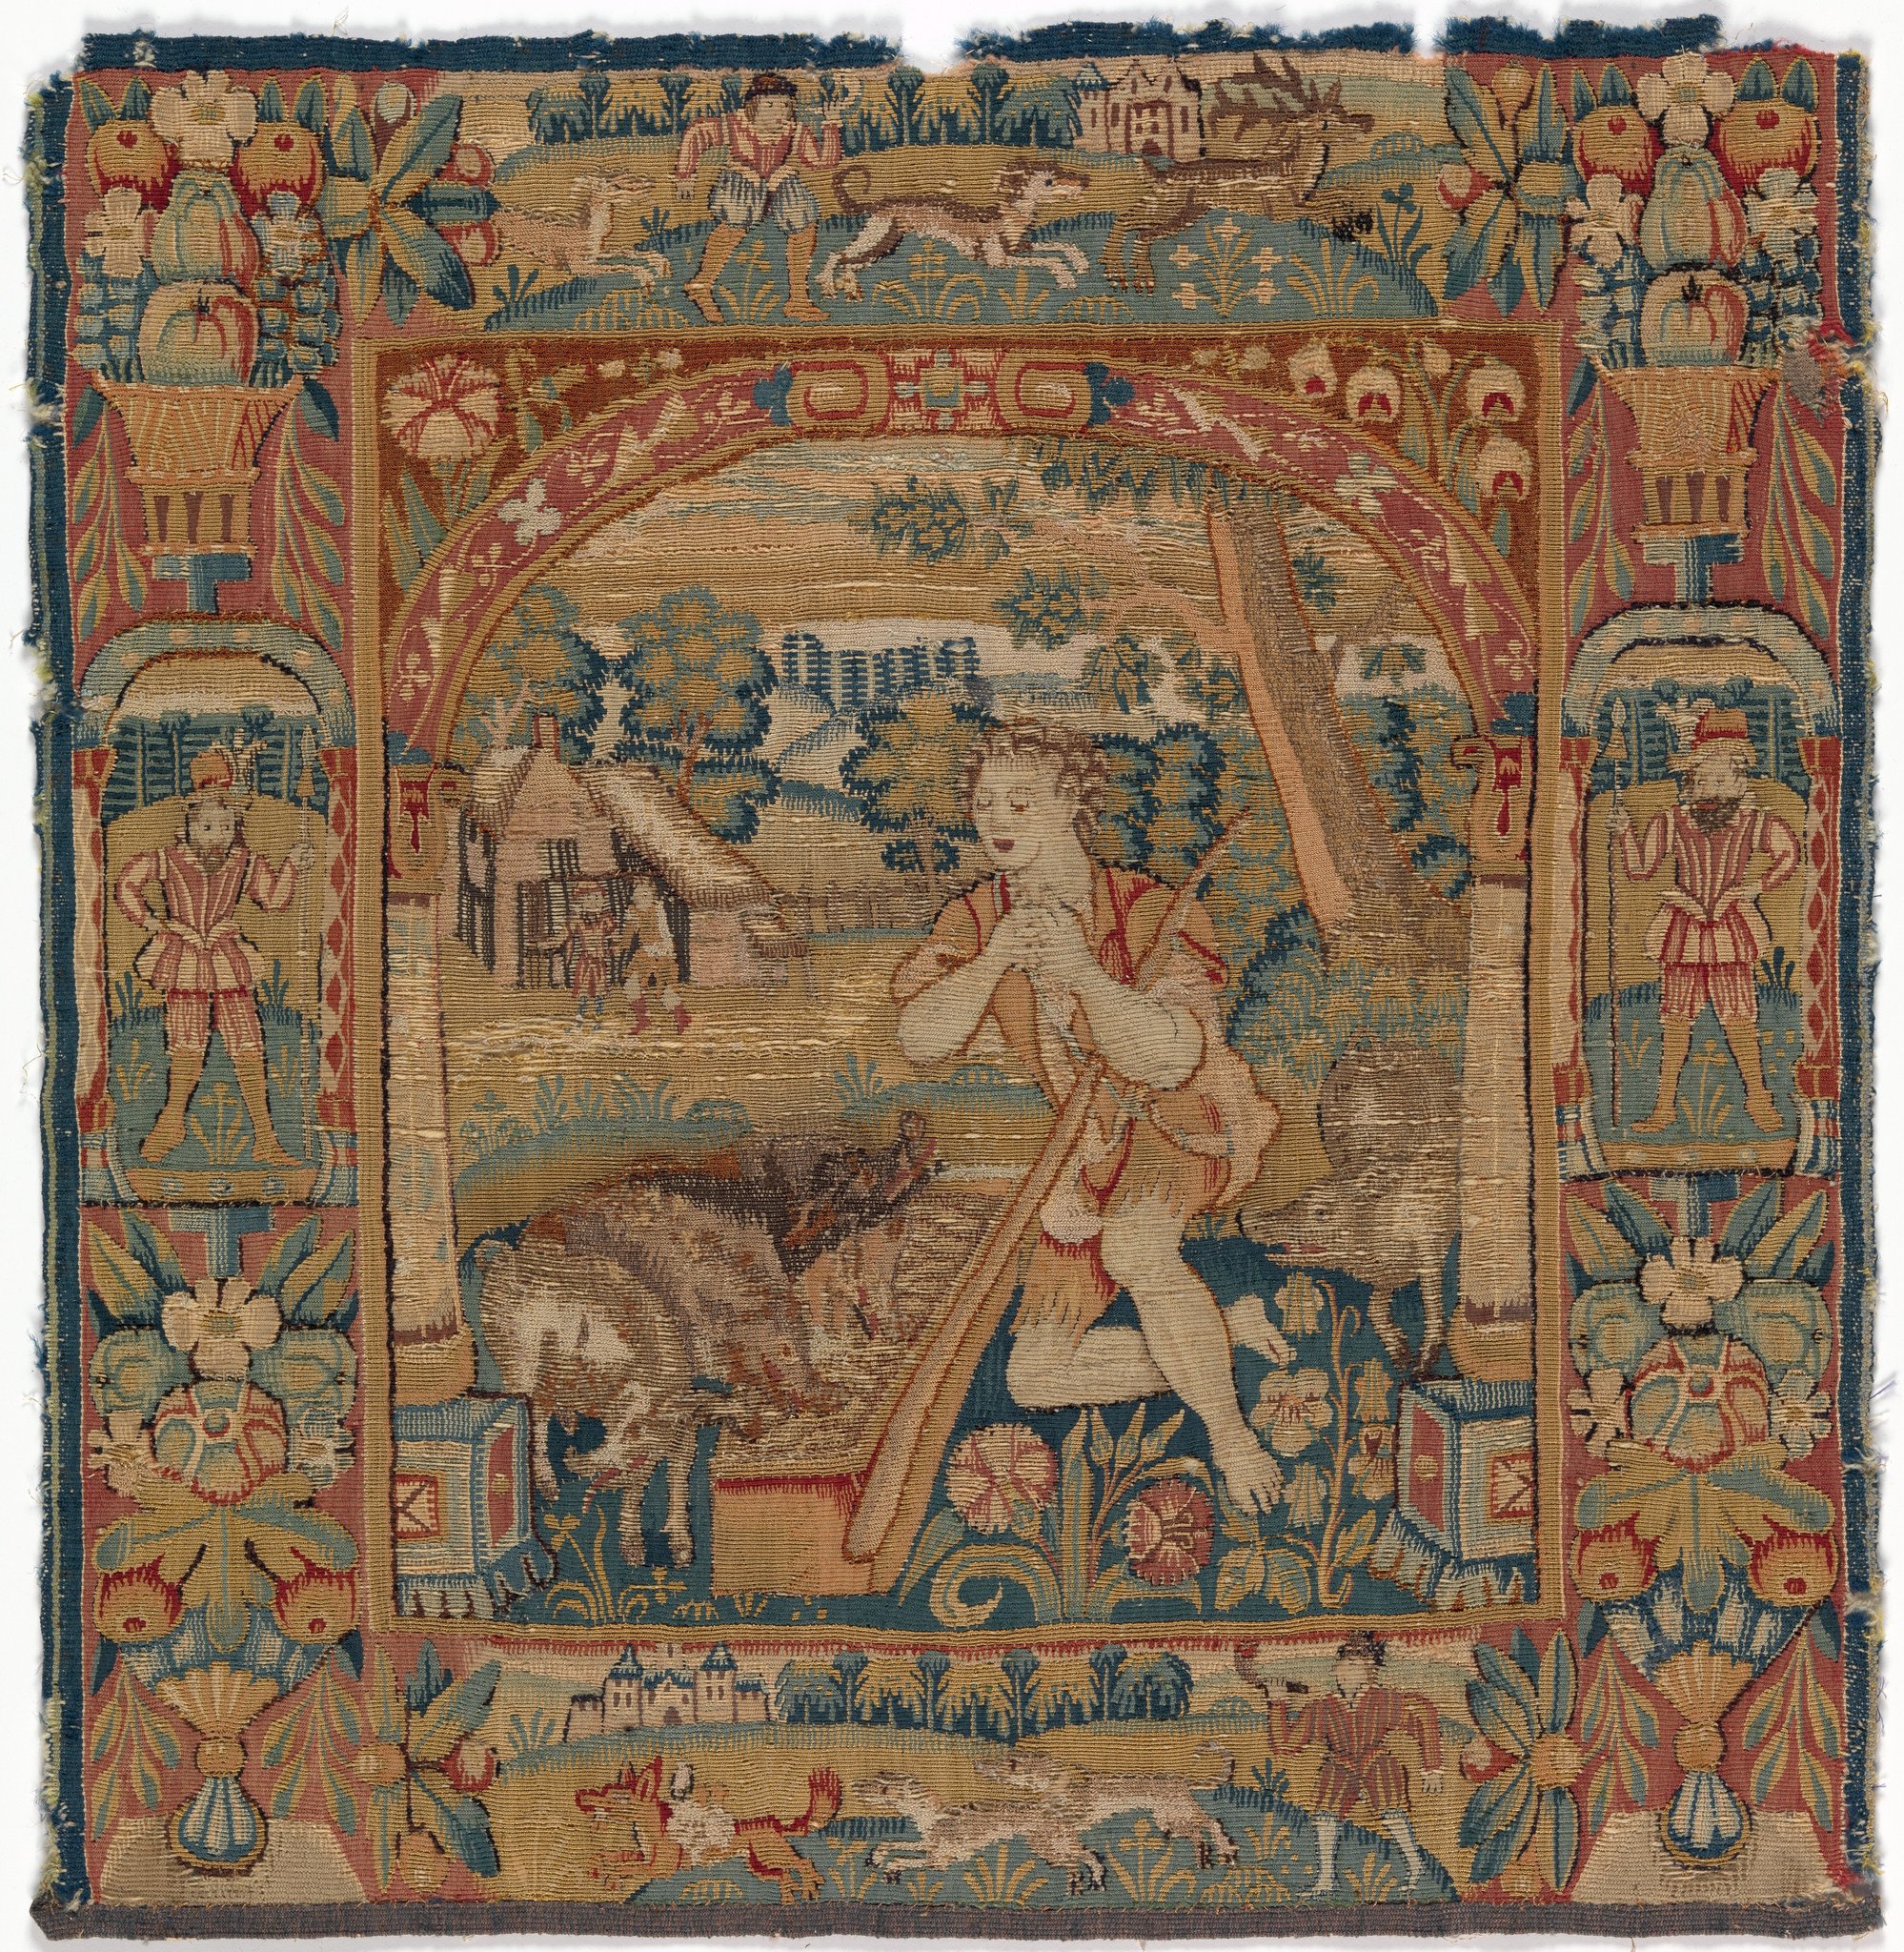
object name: cushion cover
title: "The Repentance of the Prodigal Son" from a set of six of The Parable of the Prodigal Son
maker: anonymous workshop, british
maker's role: artist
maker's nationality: british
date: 1601-1633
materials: silk, wool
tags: men,deer,dogs,pigs